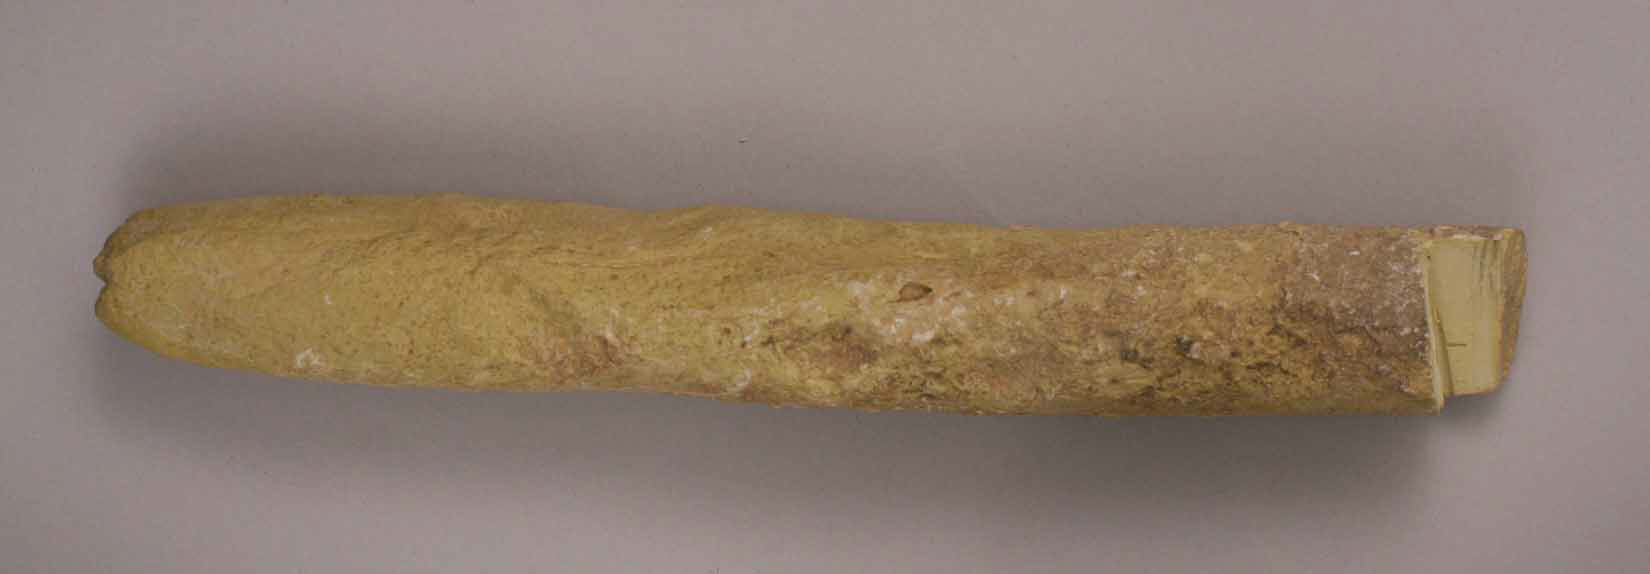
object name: kiln rod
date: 801-900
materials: earthenware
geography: iraq